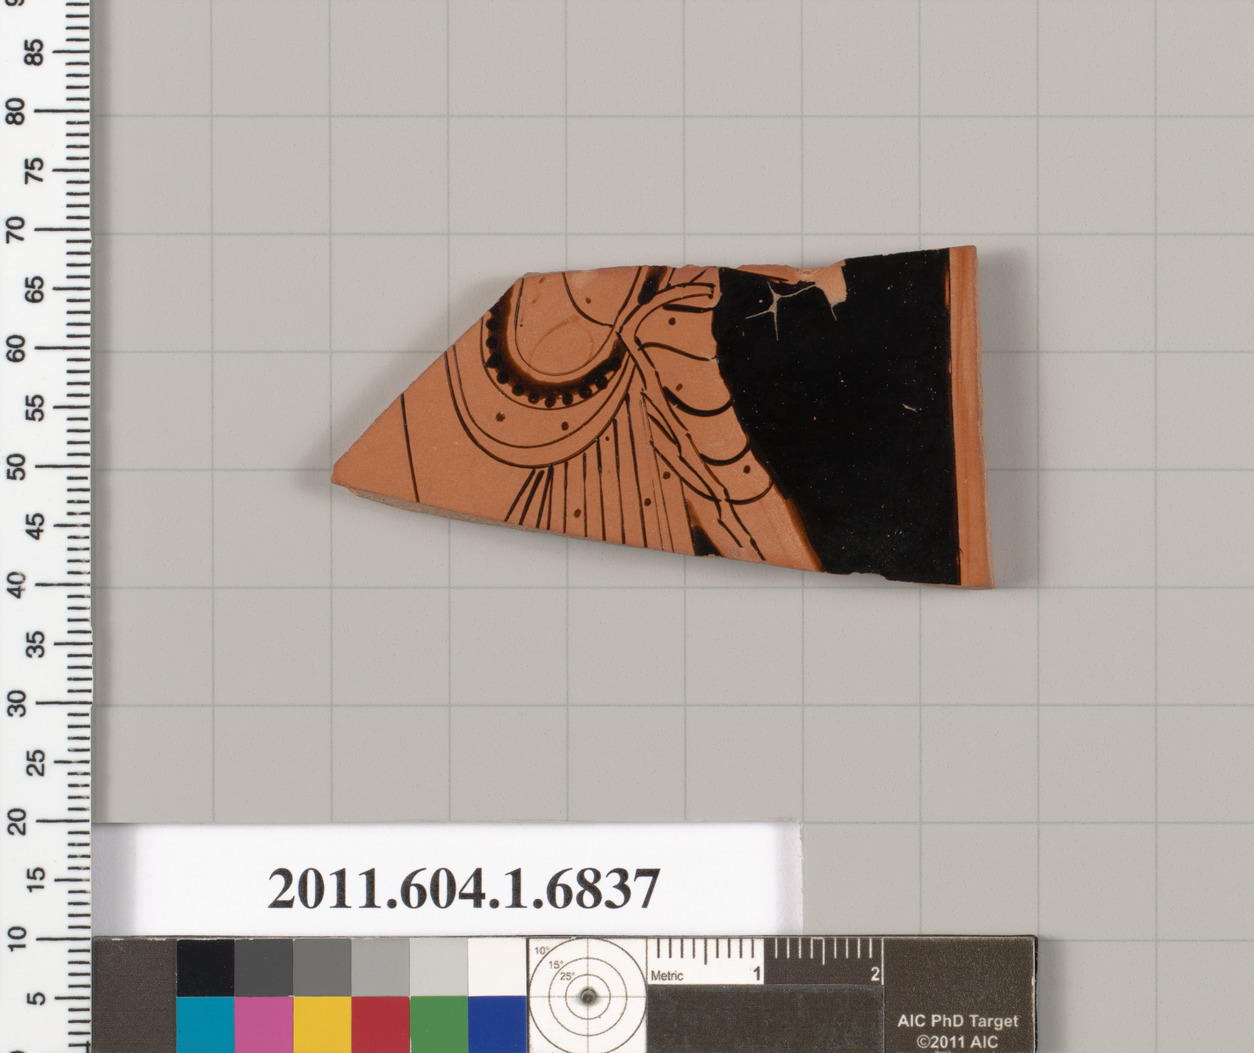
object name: kylix fragment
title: Terracotta fragment of a kylix (drinking cup)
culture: greek, attic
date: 490-470 BCE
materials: terracotta